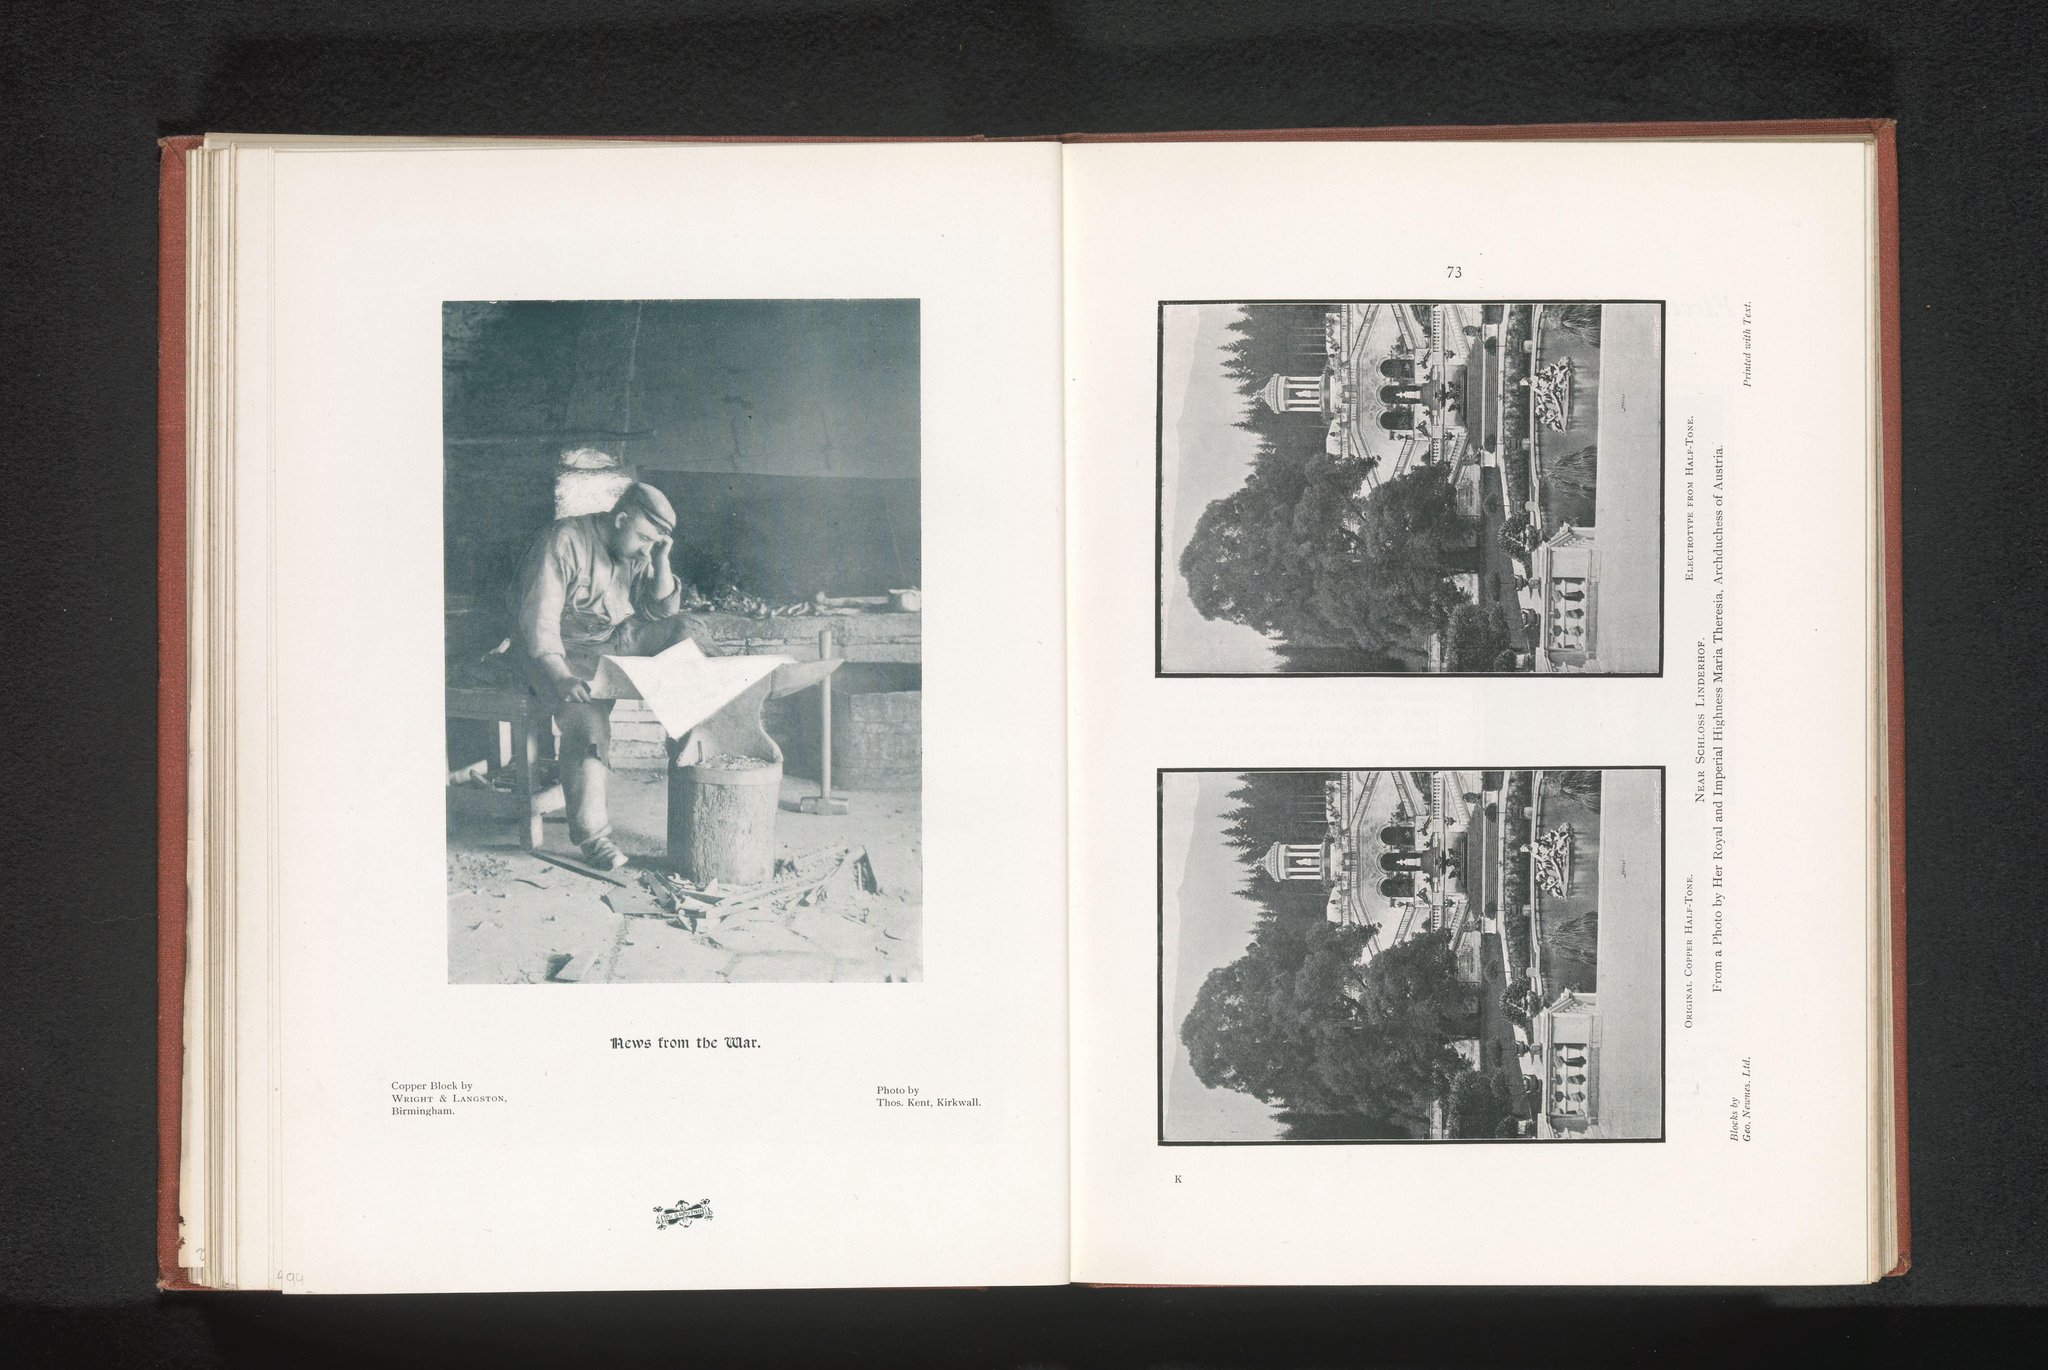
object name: photomechanical print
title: News from the war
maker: t. kent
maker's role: fotograaf, illustrator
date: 1895-1900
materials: paper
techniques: autotype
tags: reading, smith, blacksmith, tools, aids, implements ~ crafts and industries: anvil